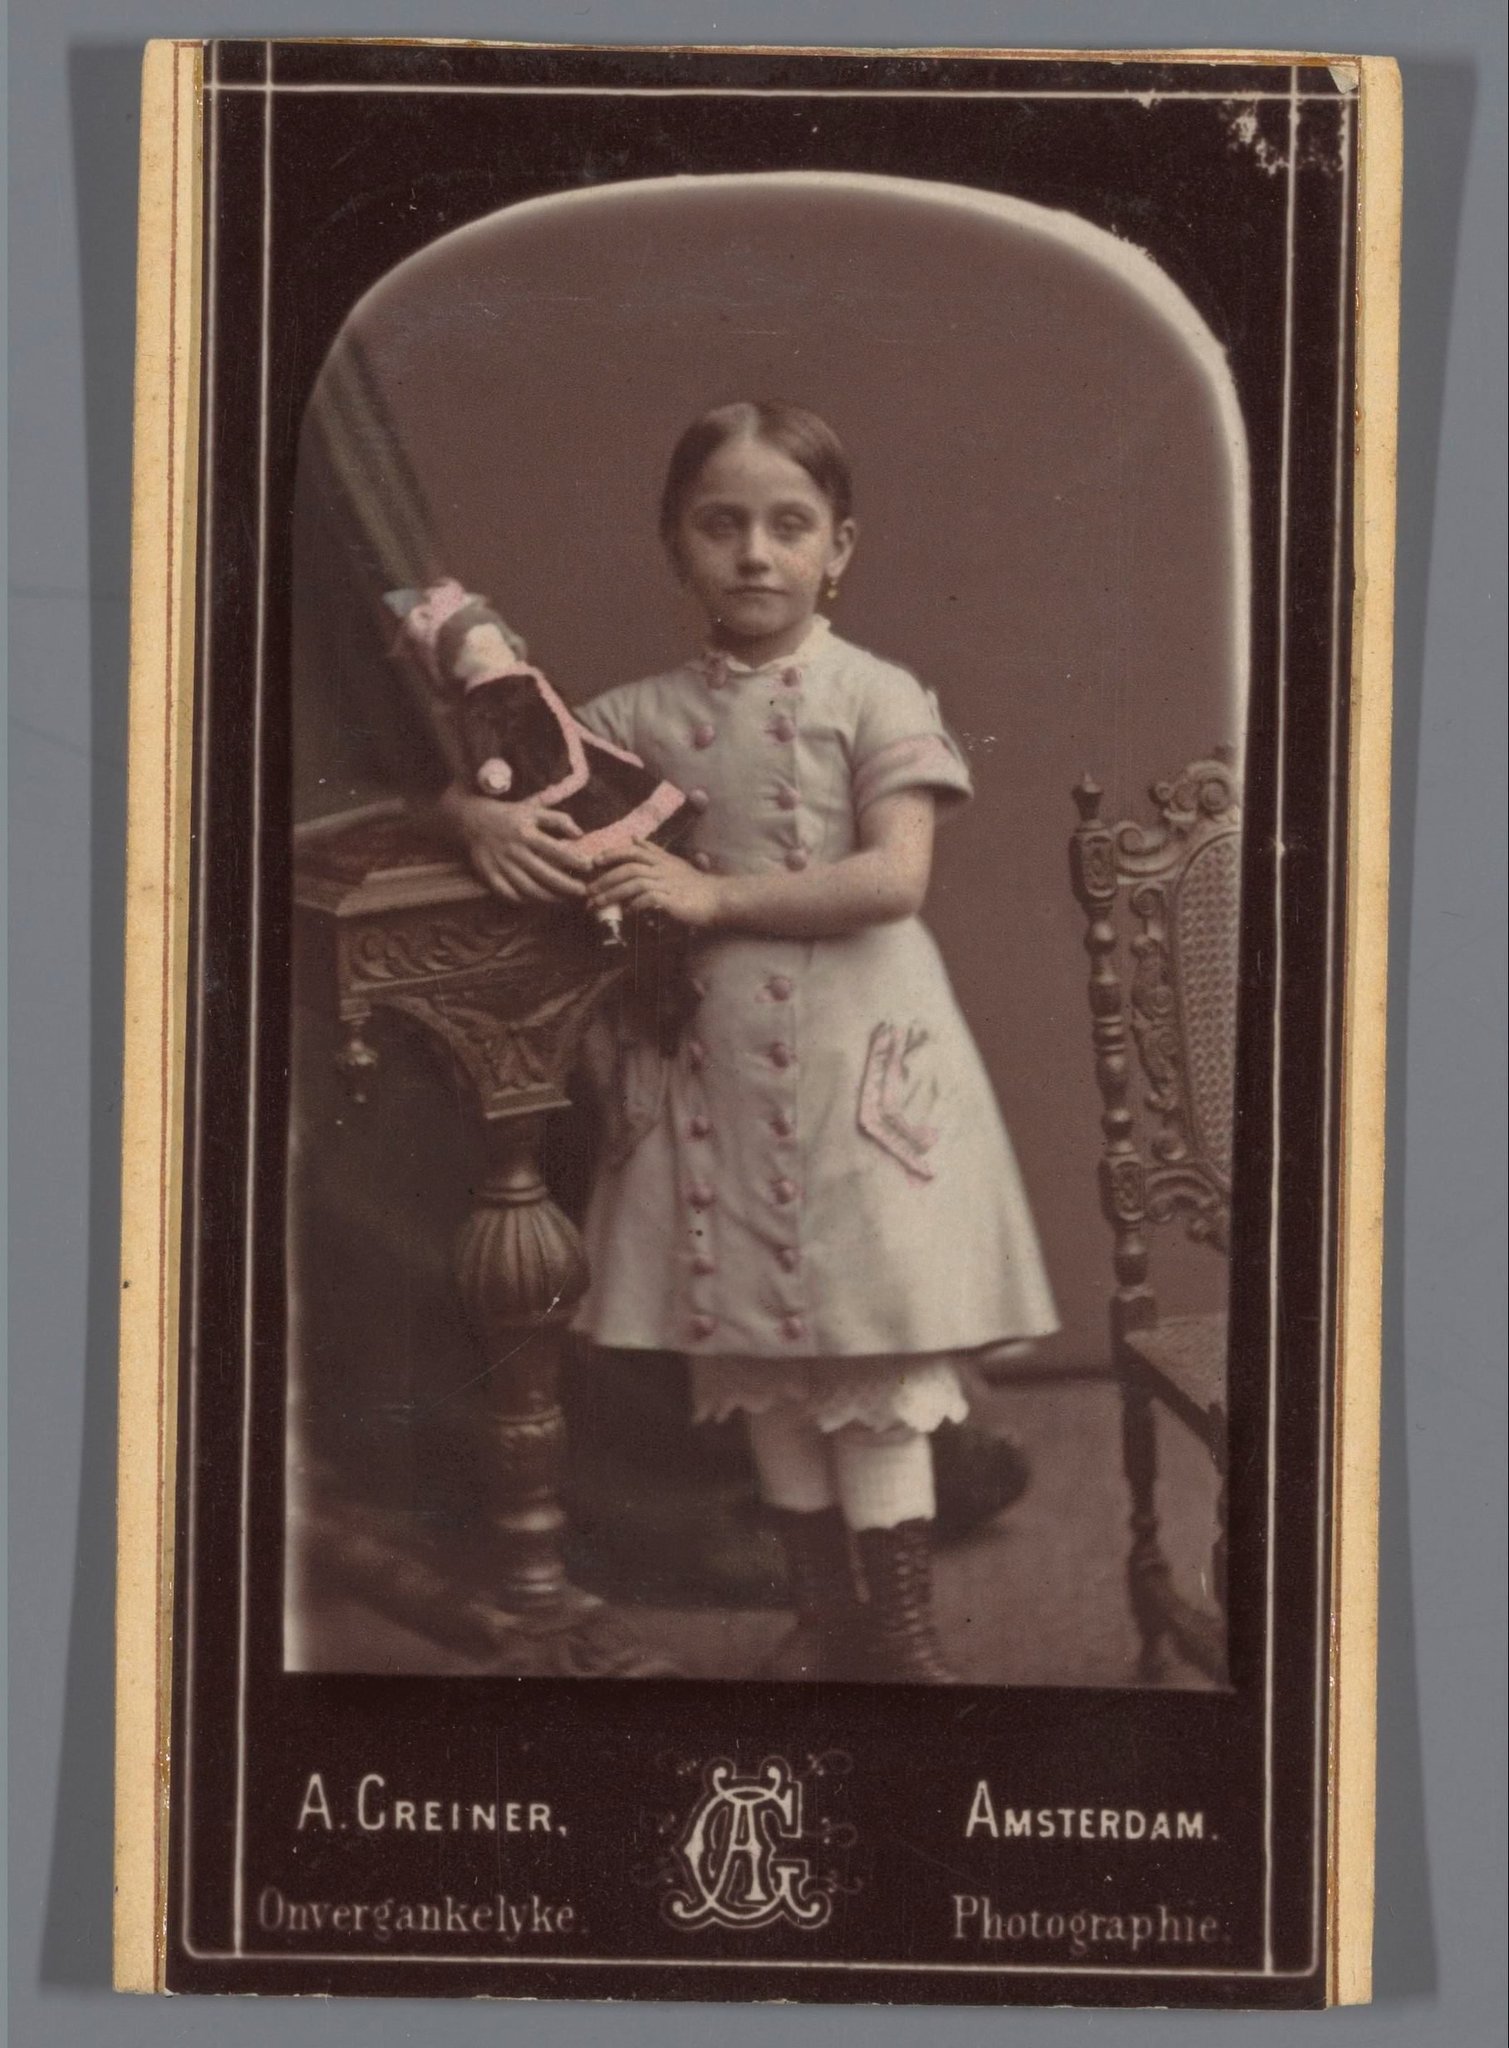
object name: photograph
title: Portret van een onbekend meisje met pop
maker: albert greiner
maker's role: fotograaf, fotostudio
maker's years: 1833-1890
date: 1861-1874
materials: cardboard, celluloid, paper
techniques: albumen print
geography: amsterdam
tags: historical persons, girl (child between toddler and youth), (playing with) dolls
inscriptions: inscription: ‘AG. A. GREINER AMSTERDAM./ Onvergankelyke Photographie’, inscription: ‘AG/ A. GREINER/ Photograf/ AMSTERDAM/ NIEUWENDIJK L. 89’, stamp: ‘ONVERANDERLYKE KOOLDRUK’